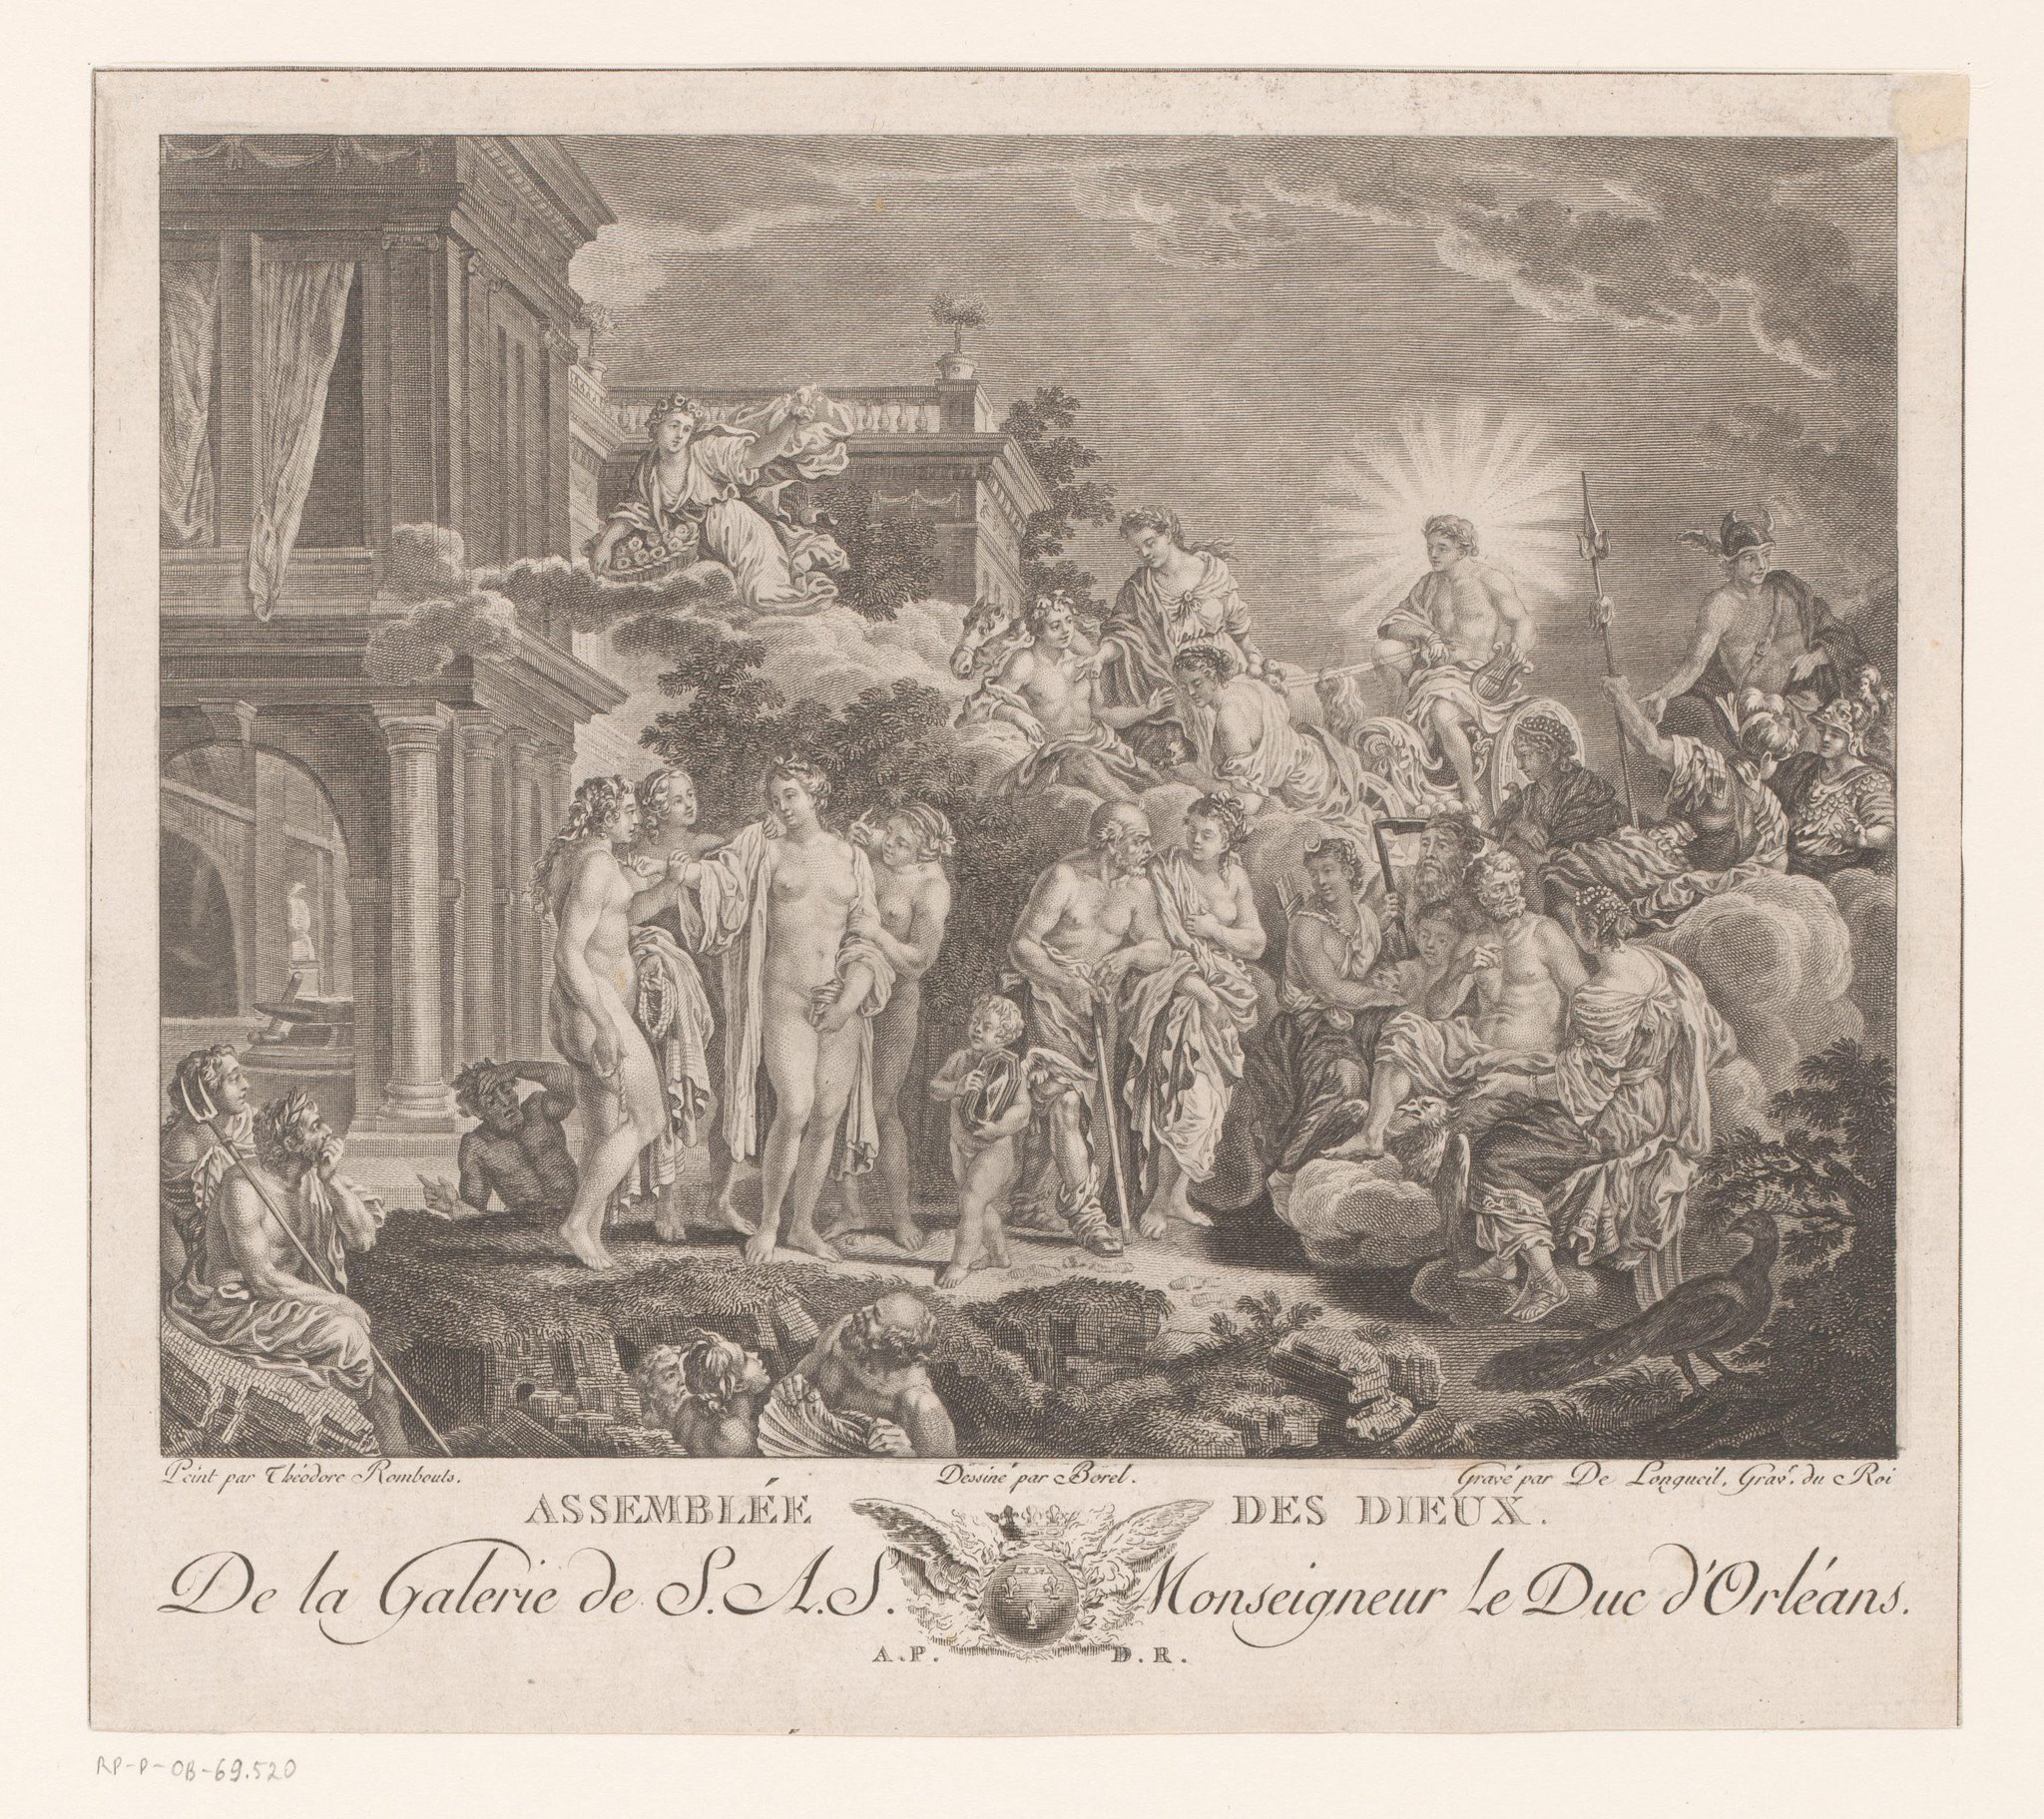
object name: print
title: Schilderijen uit de collectie van de Hertog van Orléans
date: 1786-1808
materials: paper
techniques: engraving, etching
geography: france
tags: the olympian gods together: jupiter, juno, neptune, ceres, apollo, diana, mars, venus, mercury, minerva, vulcan, vesta (or bacchus), armorial bearing, heraldry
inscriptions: collector's mark: Lugt 2228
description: Verzameling Griekse goden bij elkaar voor een tempel: Apollo in zijn zegewagen, naast hem Mercurius, Minerva en Venus. Op de voorgrond Diana, Jupiter en Juno en Vulcanus.